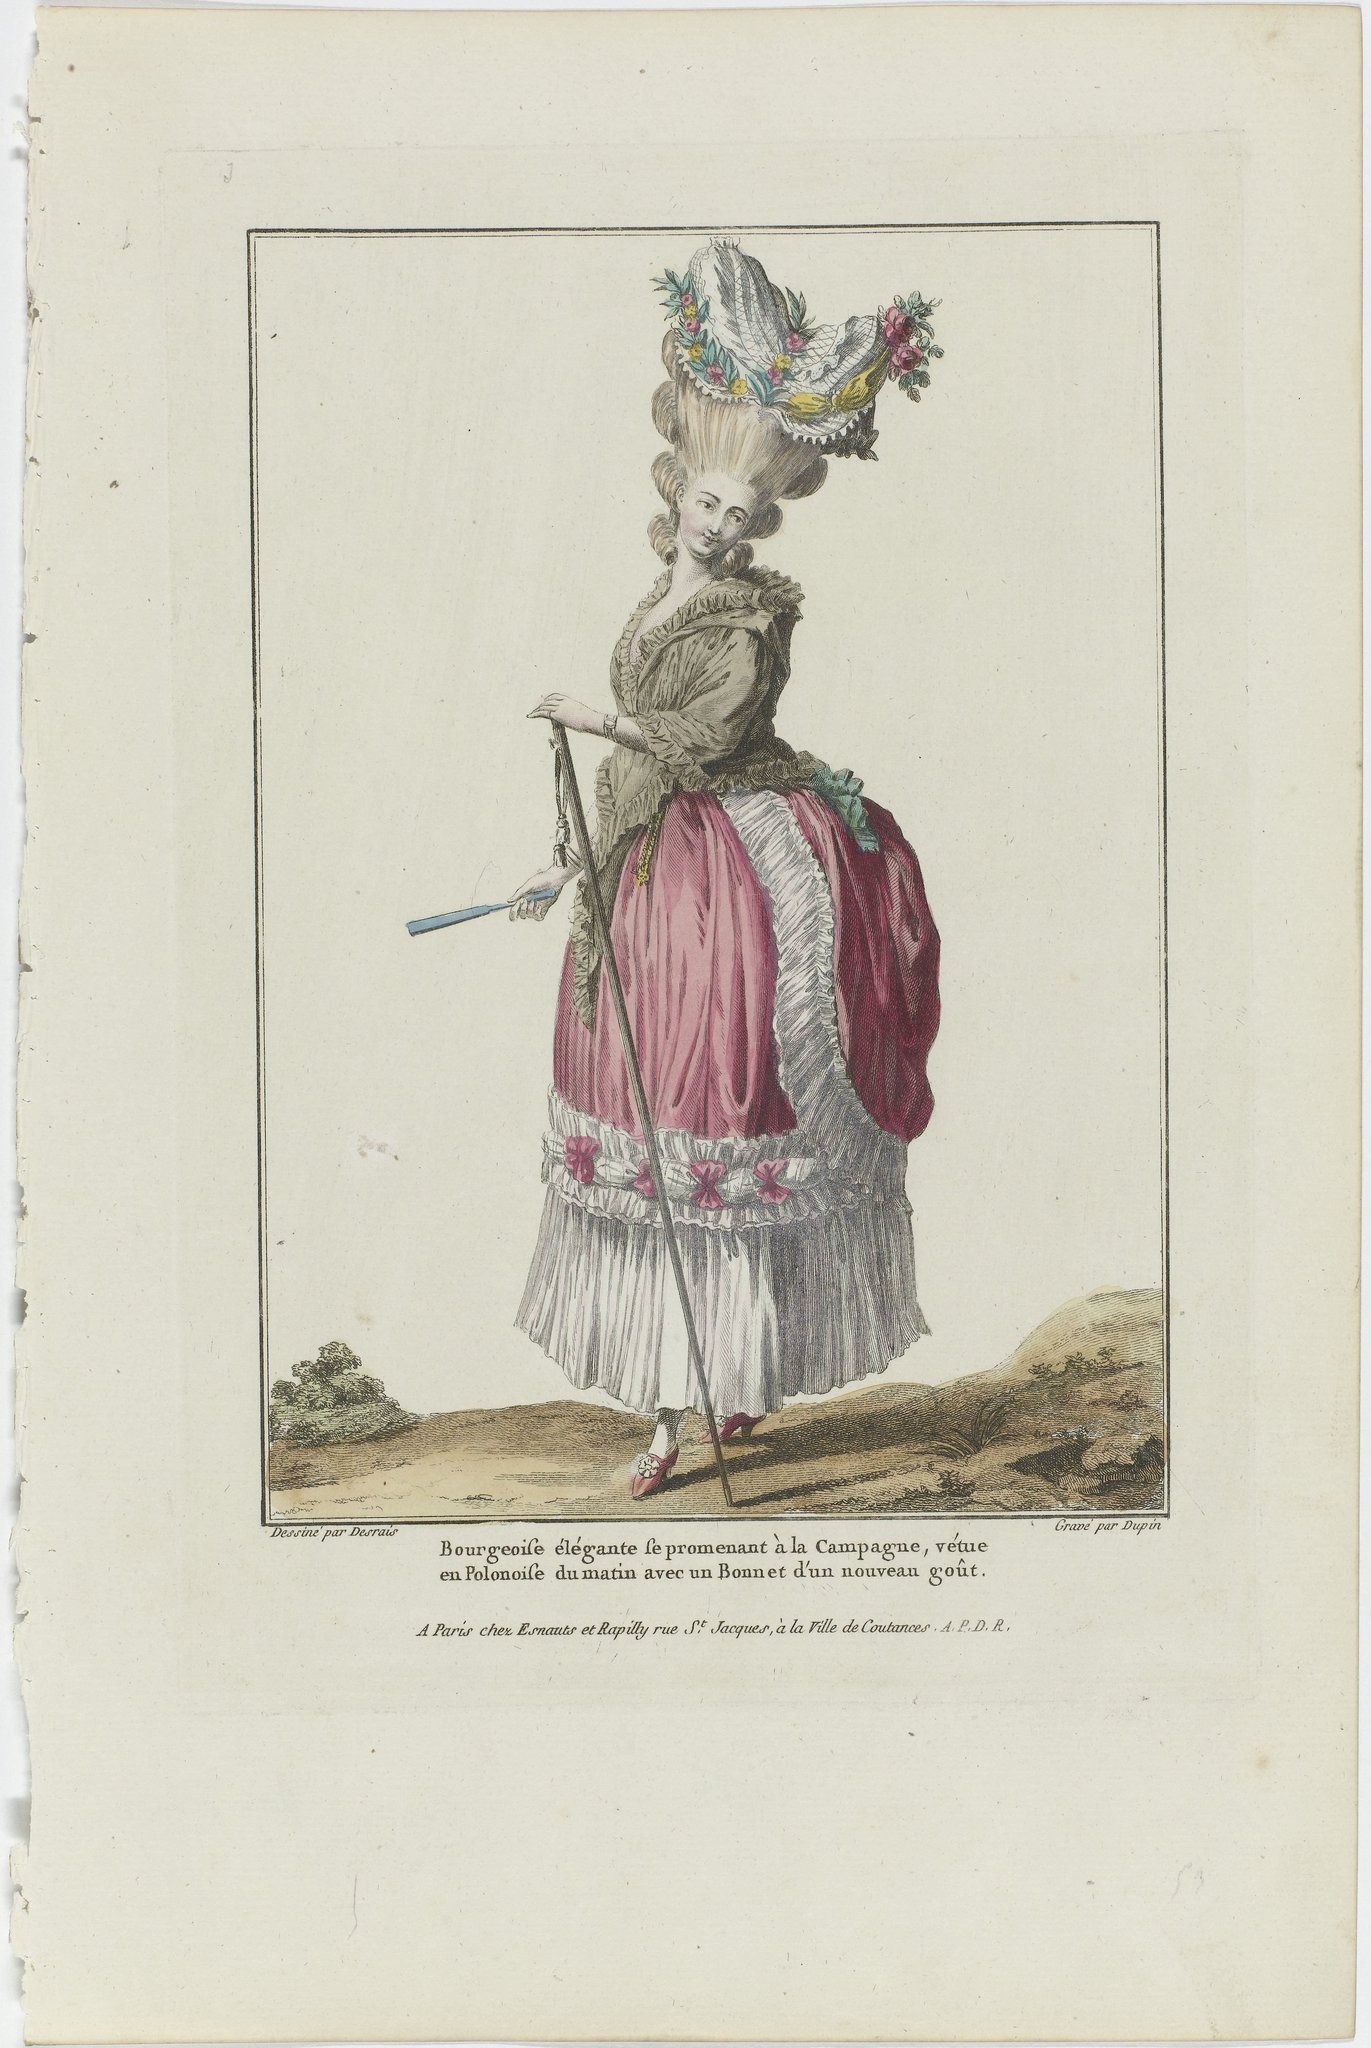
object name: fashion print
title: Gallerie des Modes et Costumes Français, 1778, J 53 : Bourgeoise élégant (...)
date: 1778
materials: paper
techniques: engraving, hand coloring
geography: paris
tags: clothing for the upper part of the body (+ women's clothes), walking-stick, staff, cane (+ women's clothes), head-gear (bonnet) (+ women's clothes), fashion plates, shoes, sandals (+ women's clothes), skirt (+ women's clothes), fan (+ women's clothes), dress, gown: robe à la polonaise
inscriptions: caption: ‘Bourgeoise élégante se promenant à la Campagne, vétue en Polonoise du matin avec un Bonnet d'un nouveau goût.’, address: ‘A Paris chez Esnauts et Rapilly rue St. Jacques, à la Ville de Coutances. A.P.D.R.’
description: Een elegante burgervrouw, wandelend op het platteland. Zij draagt een 'robe à la Polonaise' voor de ochtend, waarover een mantelet van tafzijde met capuchon. Op het hoog opgekamde kapsel een 'Bonnet à l'Ameriquaine' ('volgens de nieuwste smaak') . Waaier in de rechter-, wandelstok met linten in de linkerhand. Verdere accessoires: armbanden, ring, chatelaine en schoenen met hakken en rozetten. Prent uit serie J. 9e Cahier des Costumes Français, 3e Suite d'Habillemens à la mode, Gallerie des Modes et Costumes Français.